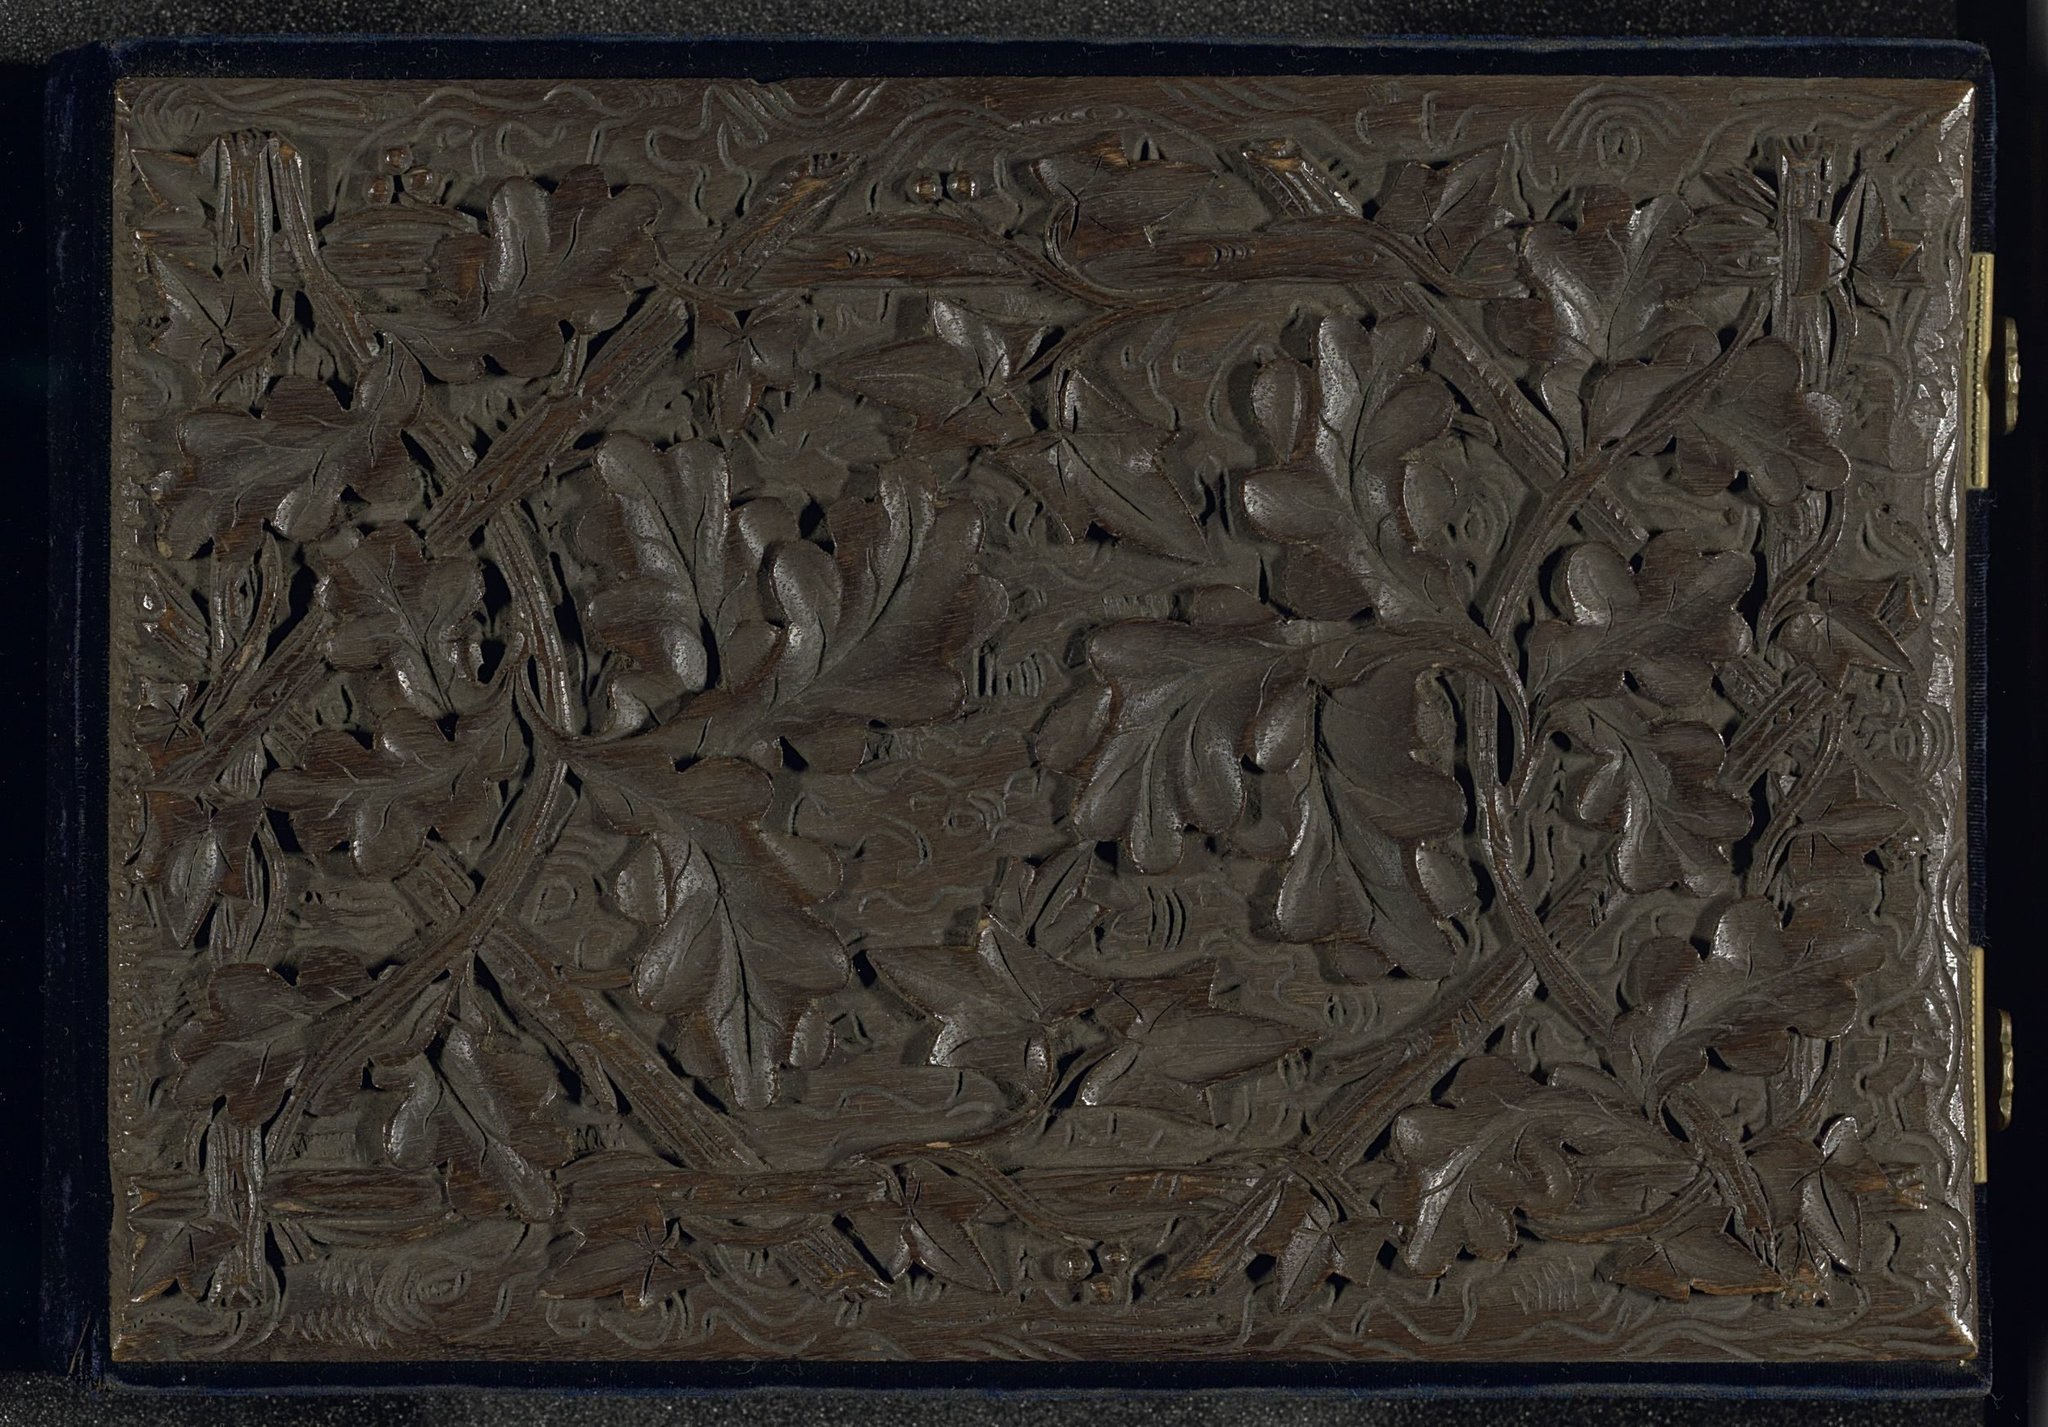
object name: slip in album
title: Fotoalbum van een reis door Zwitserland, Oostenrijk en Duitsland door de Nederlandse familie Derkinderen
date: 1864-1865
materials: cardboard, metal, paper, photographic support, velvet, wood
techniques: albumen print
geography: europe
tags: travelling; tourism, germany, austria, switzerland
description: Fotoalbum in fluwelen omslag met twee metalen goudkleurige sloten. De voor- en achterzijde zijn voorzien van panelen met houtsnijwerk met bladmotieven. Schutbladen van changeantpapier met geometrisch patroon. Het album bevat 24 insteekbladen met goud op snee. Daarin 86 foto's en 3 prenten, elk op het formaat van een carte-de-visite. Elke pagina heeft twee passe-partouts, elk versierd met een goudkleurige omlijsting. Het betreft foto's en prenten van schilderijen en van steden en landschappen in Duitsland, Oostenrijk en Zwitserland. Bijgevoegd in het album een lijst met beschrijvingen van de afbeeldingen. Het album is samengesteld tijdens een reis door de Amsterdamse familie Derkinderen.